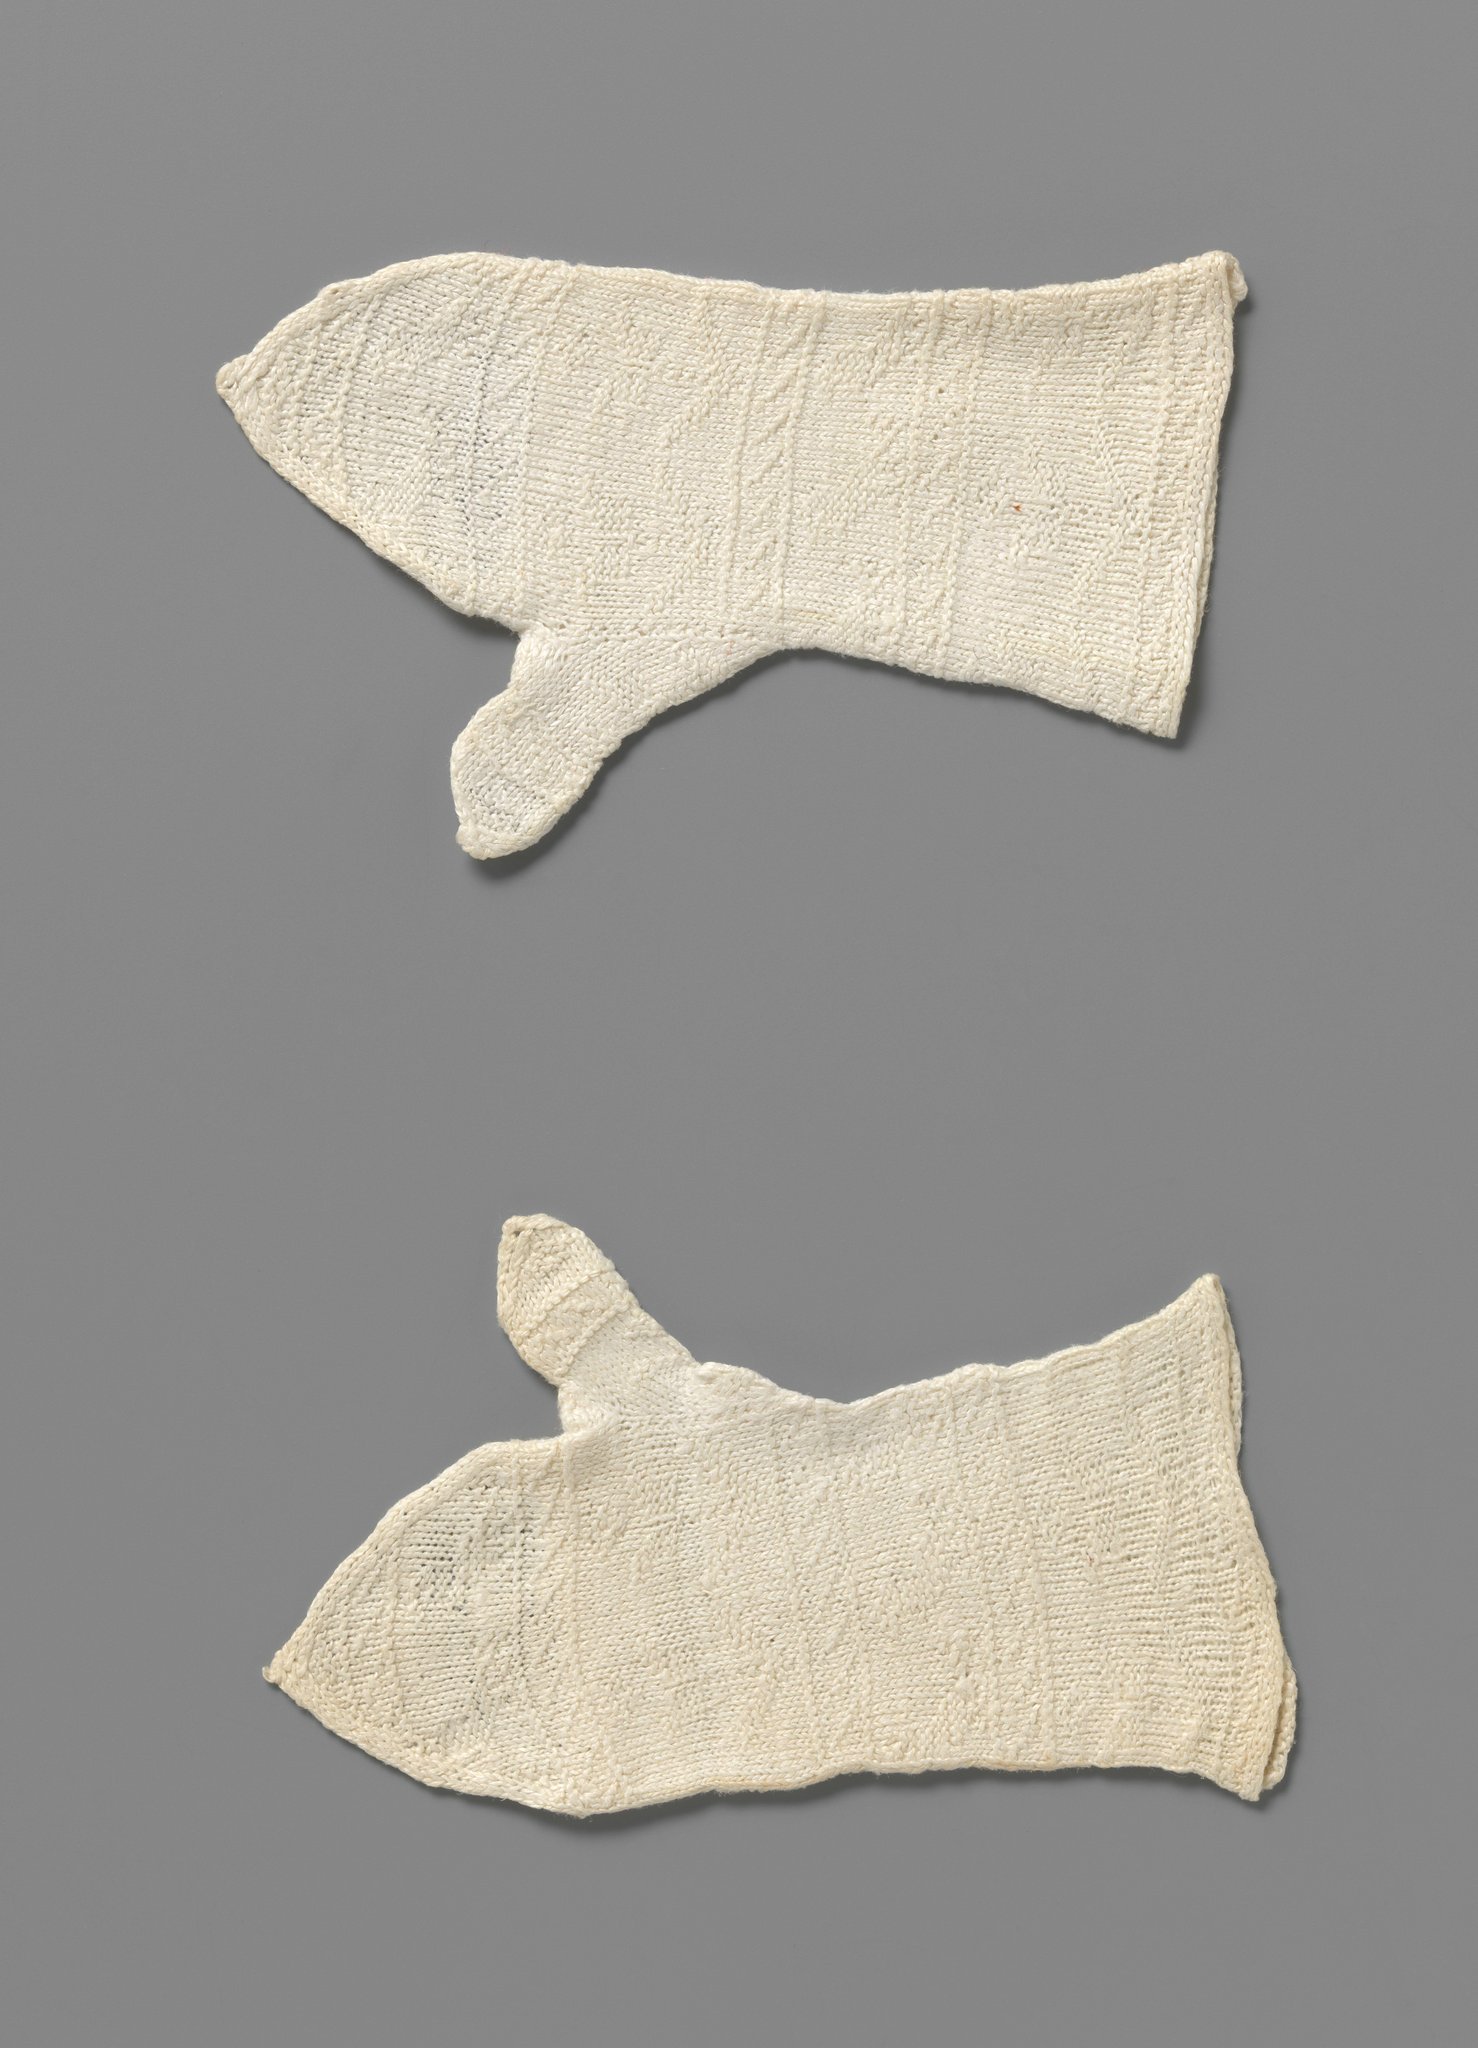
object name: childrenswear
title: Mitaine met open duim van gebreid katoen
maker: Anonymous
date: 1700-1800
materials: cotton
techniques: knitting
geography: netherlands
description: Linkermitaine van wit gebreid katoen, met open duim. Gebreid in patroon van afwisselende rijen met vogels en bloemen, voor baby of kind.